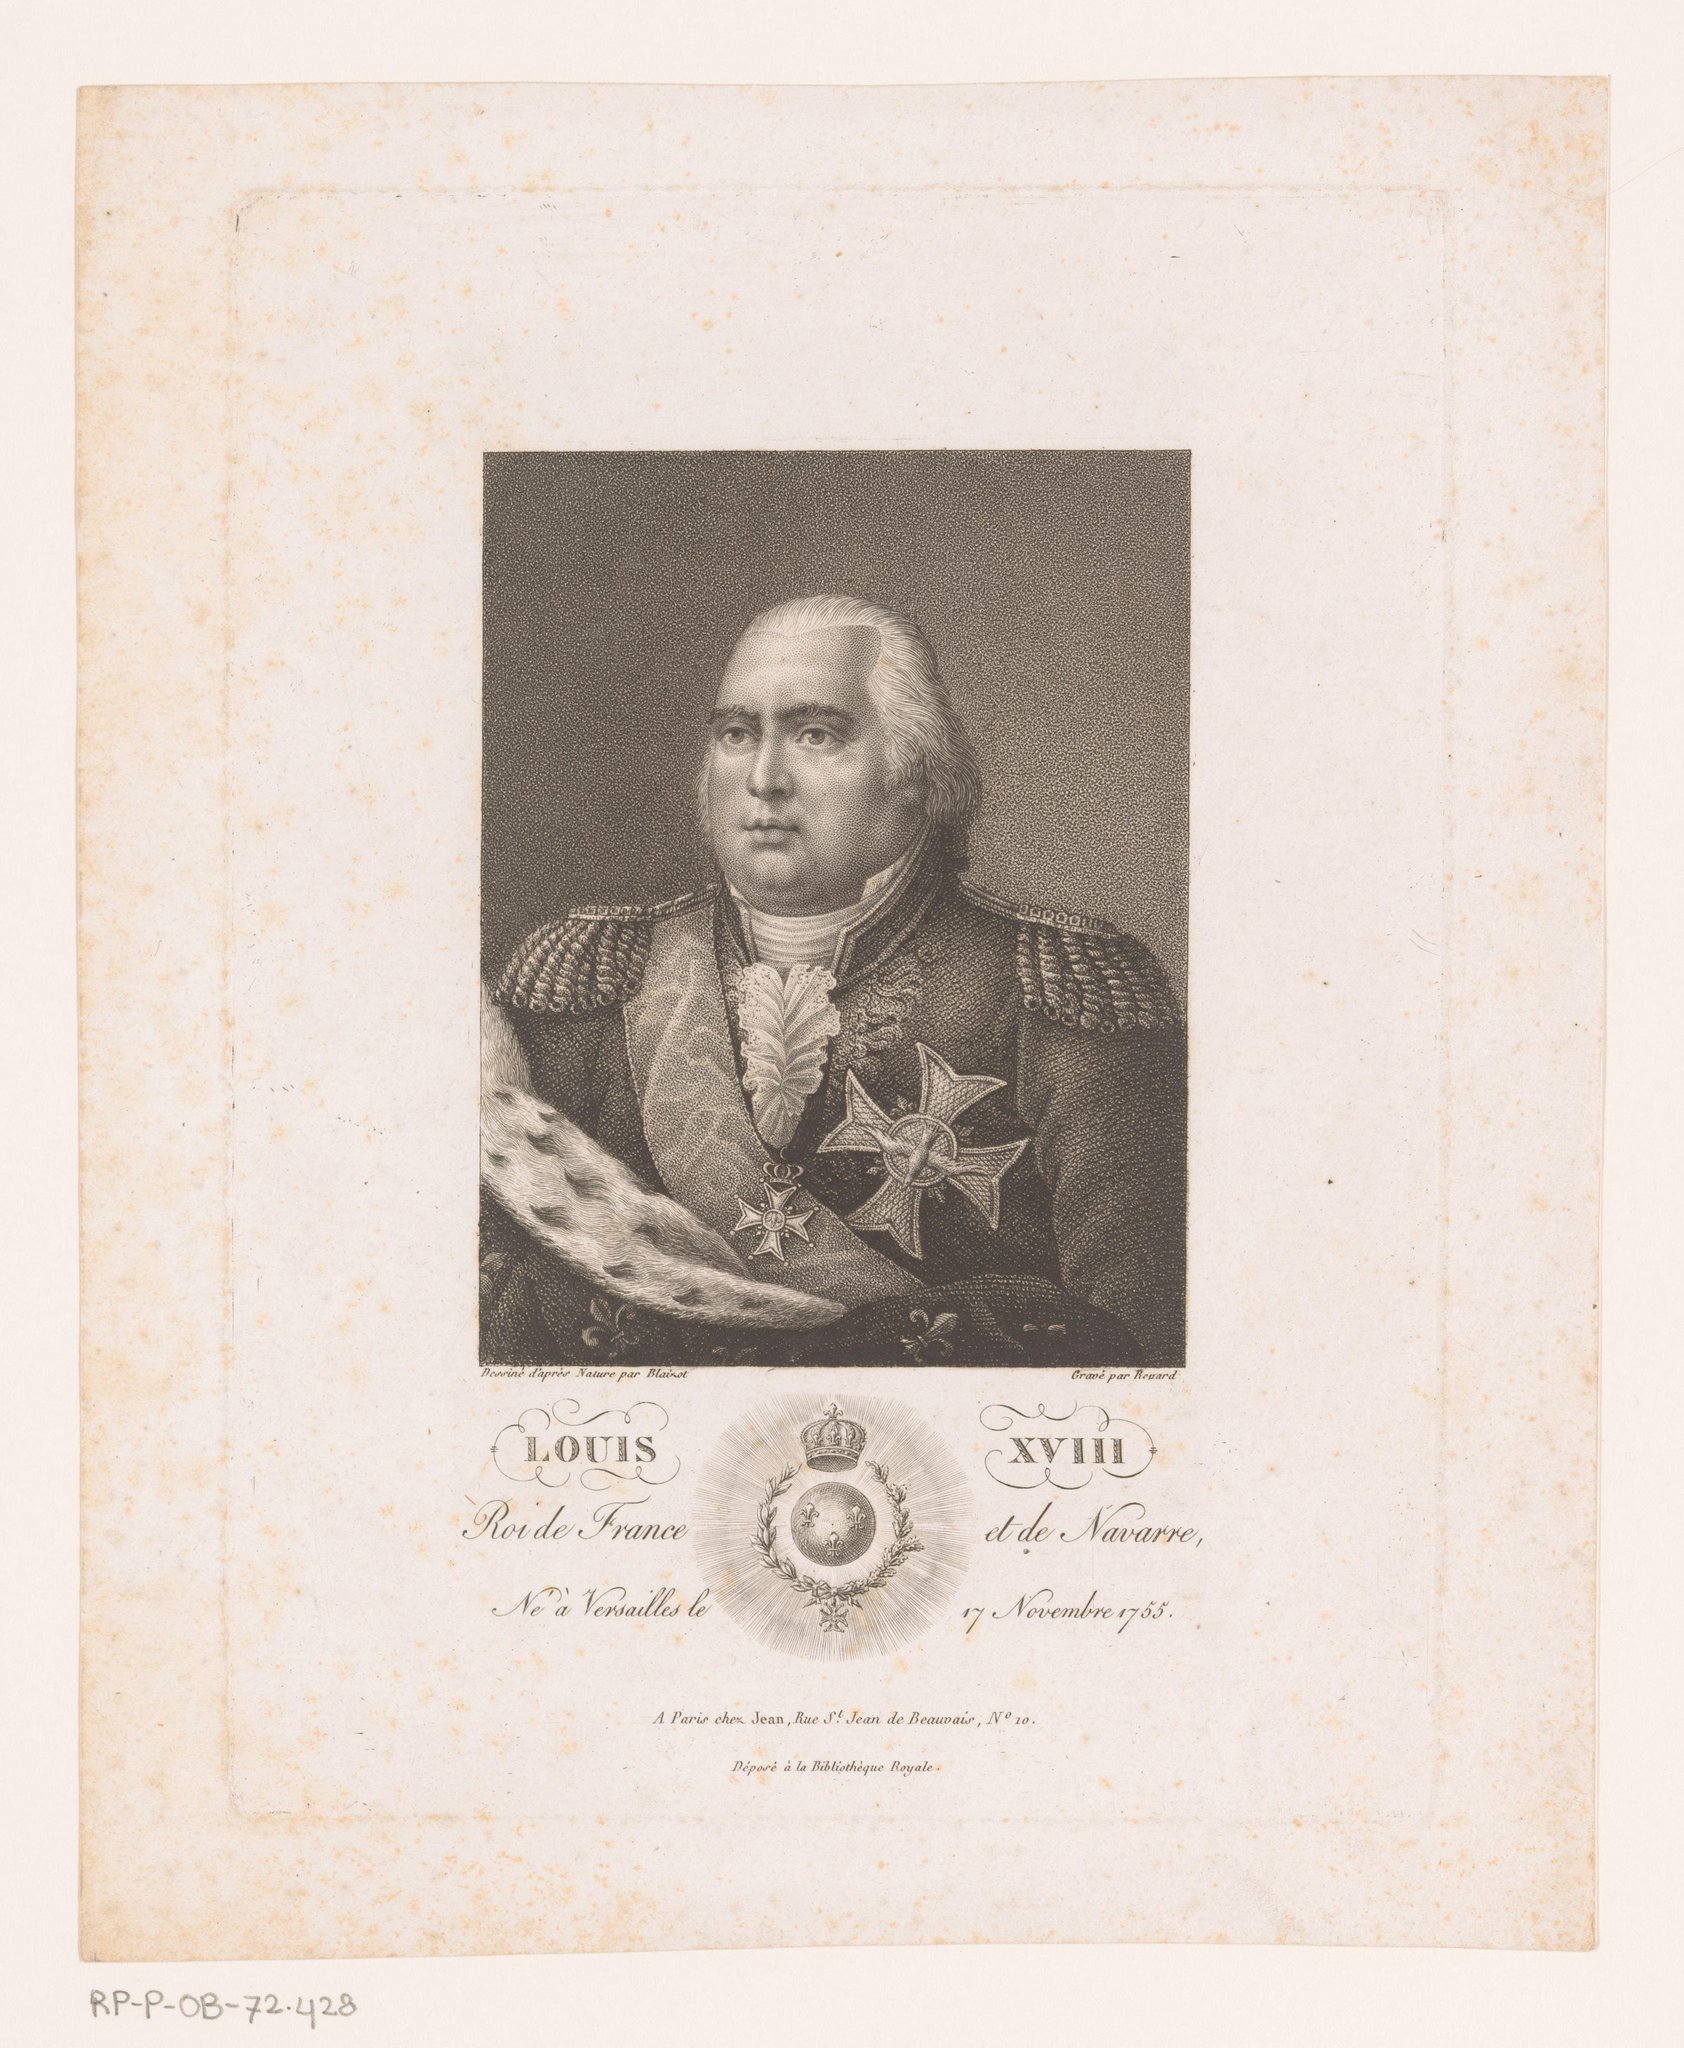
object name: print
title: Portret van Lodewijk XVIII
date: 1782-1814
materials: paper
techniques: etching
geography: paris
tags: lodewijk xviii (koning van frankrijk), historical persons, king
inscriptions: : ‘Déposé à la Bibliothèque Royale’, collector's mark: Lugt 2228, : ‘Het gelaat van Monsieur was edeler dan dat des Konings [...] Mevr. Campen, Gedenkschriften betrekkelijk Marie Antoinette’